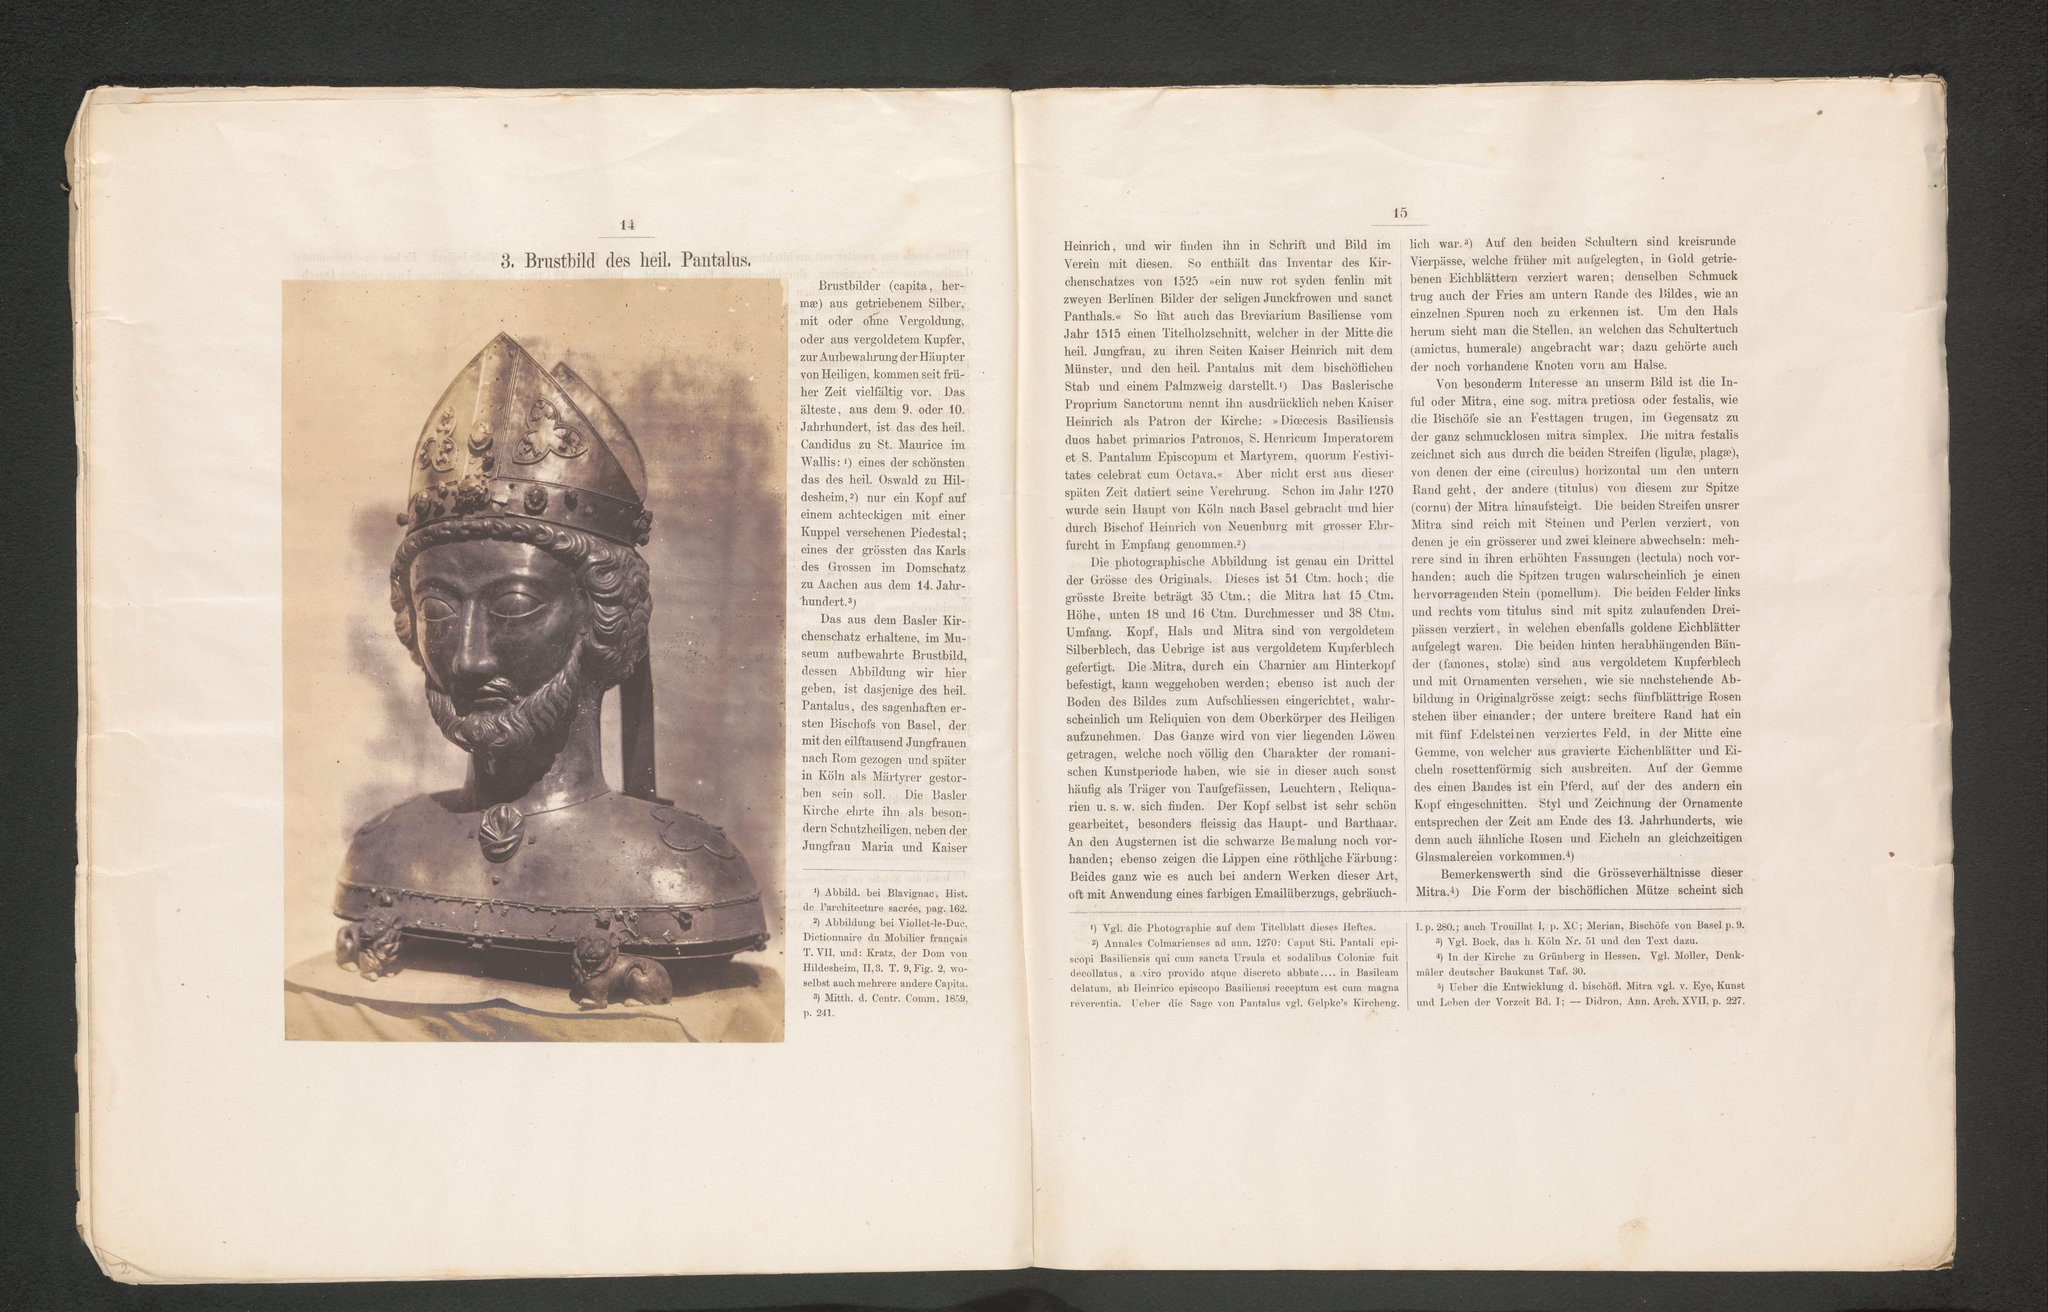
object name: page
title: Metalen buste van de heilige Pantalus van Basel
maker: jakob höflinger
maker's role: fotograaf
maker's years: 1819-1892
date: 1857-1862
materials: photographic support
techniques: salted paper print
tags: piece of sculpture, reproduction of a piece of sculpture (+ metals ~ arts), saints